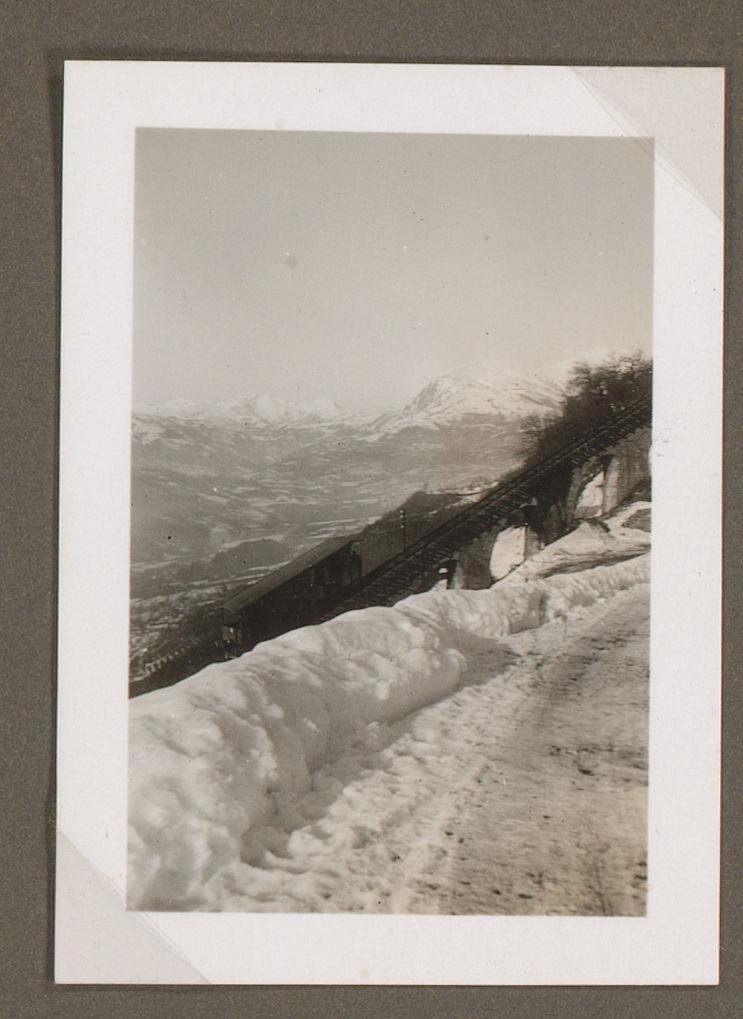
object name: photograph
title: Tandradbaan tussen Ruvigliana en Monte Brè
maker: Anonymous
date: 1934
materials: photographic support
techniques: gelatin silver print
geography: lugano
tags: rack railway, snow, mountains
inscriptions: number: ‘36’